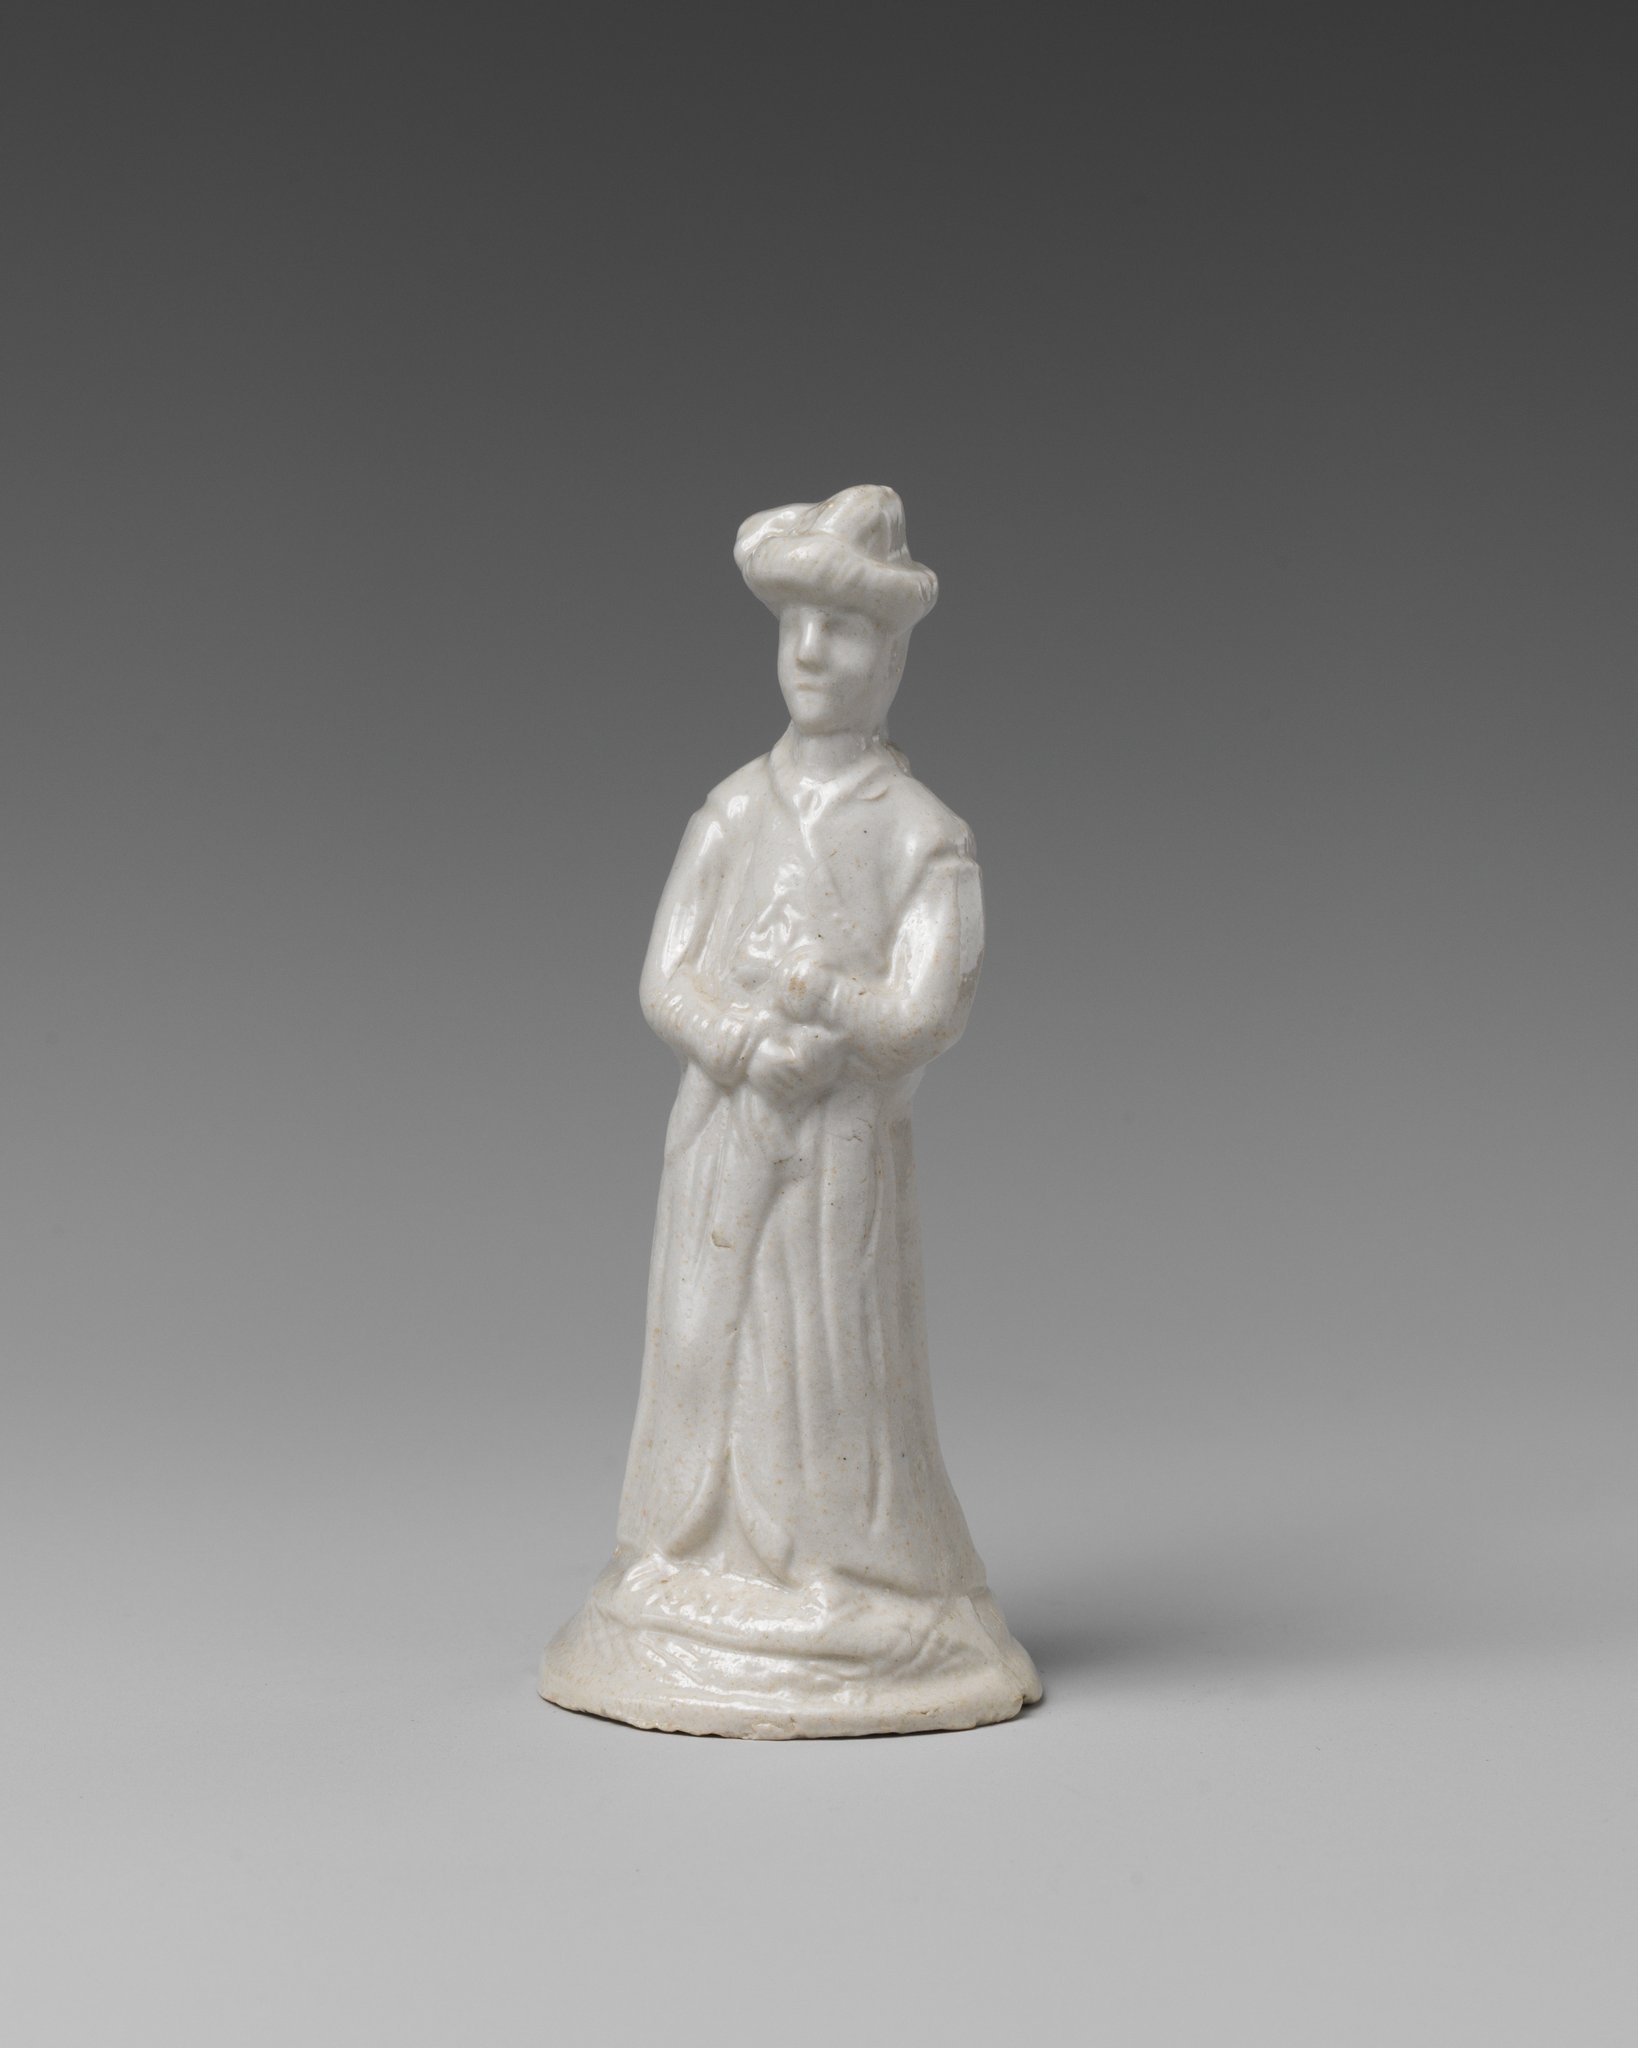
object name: figure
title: Figure of a Turk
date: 1750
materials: stoneware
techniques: salt glaze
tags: men